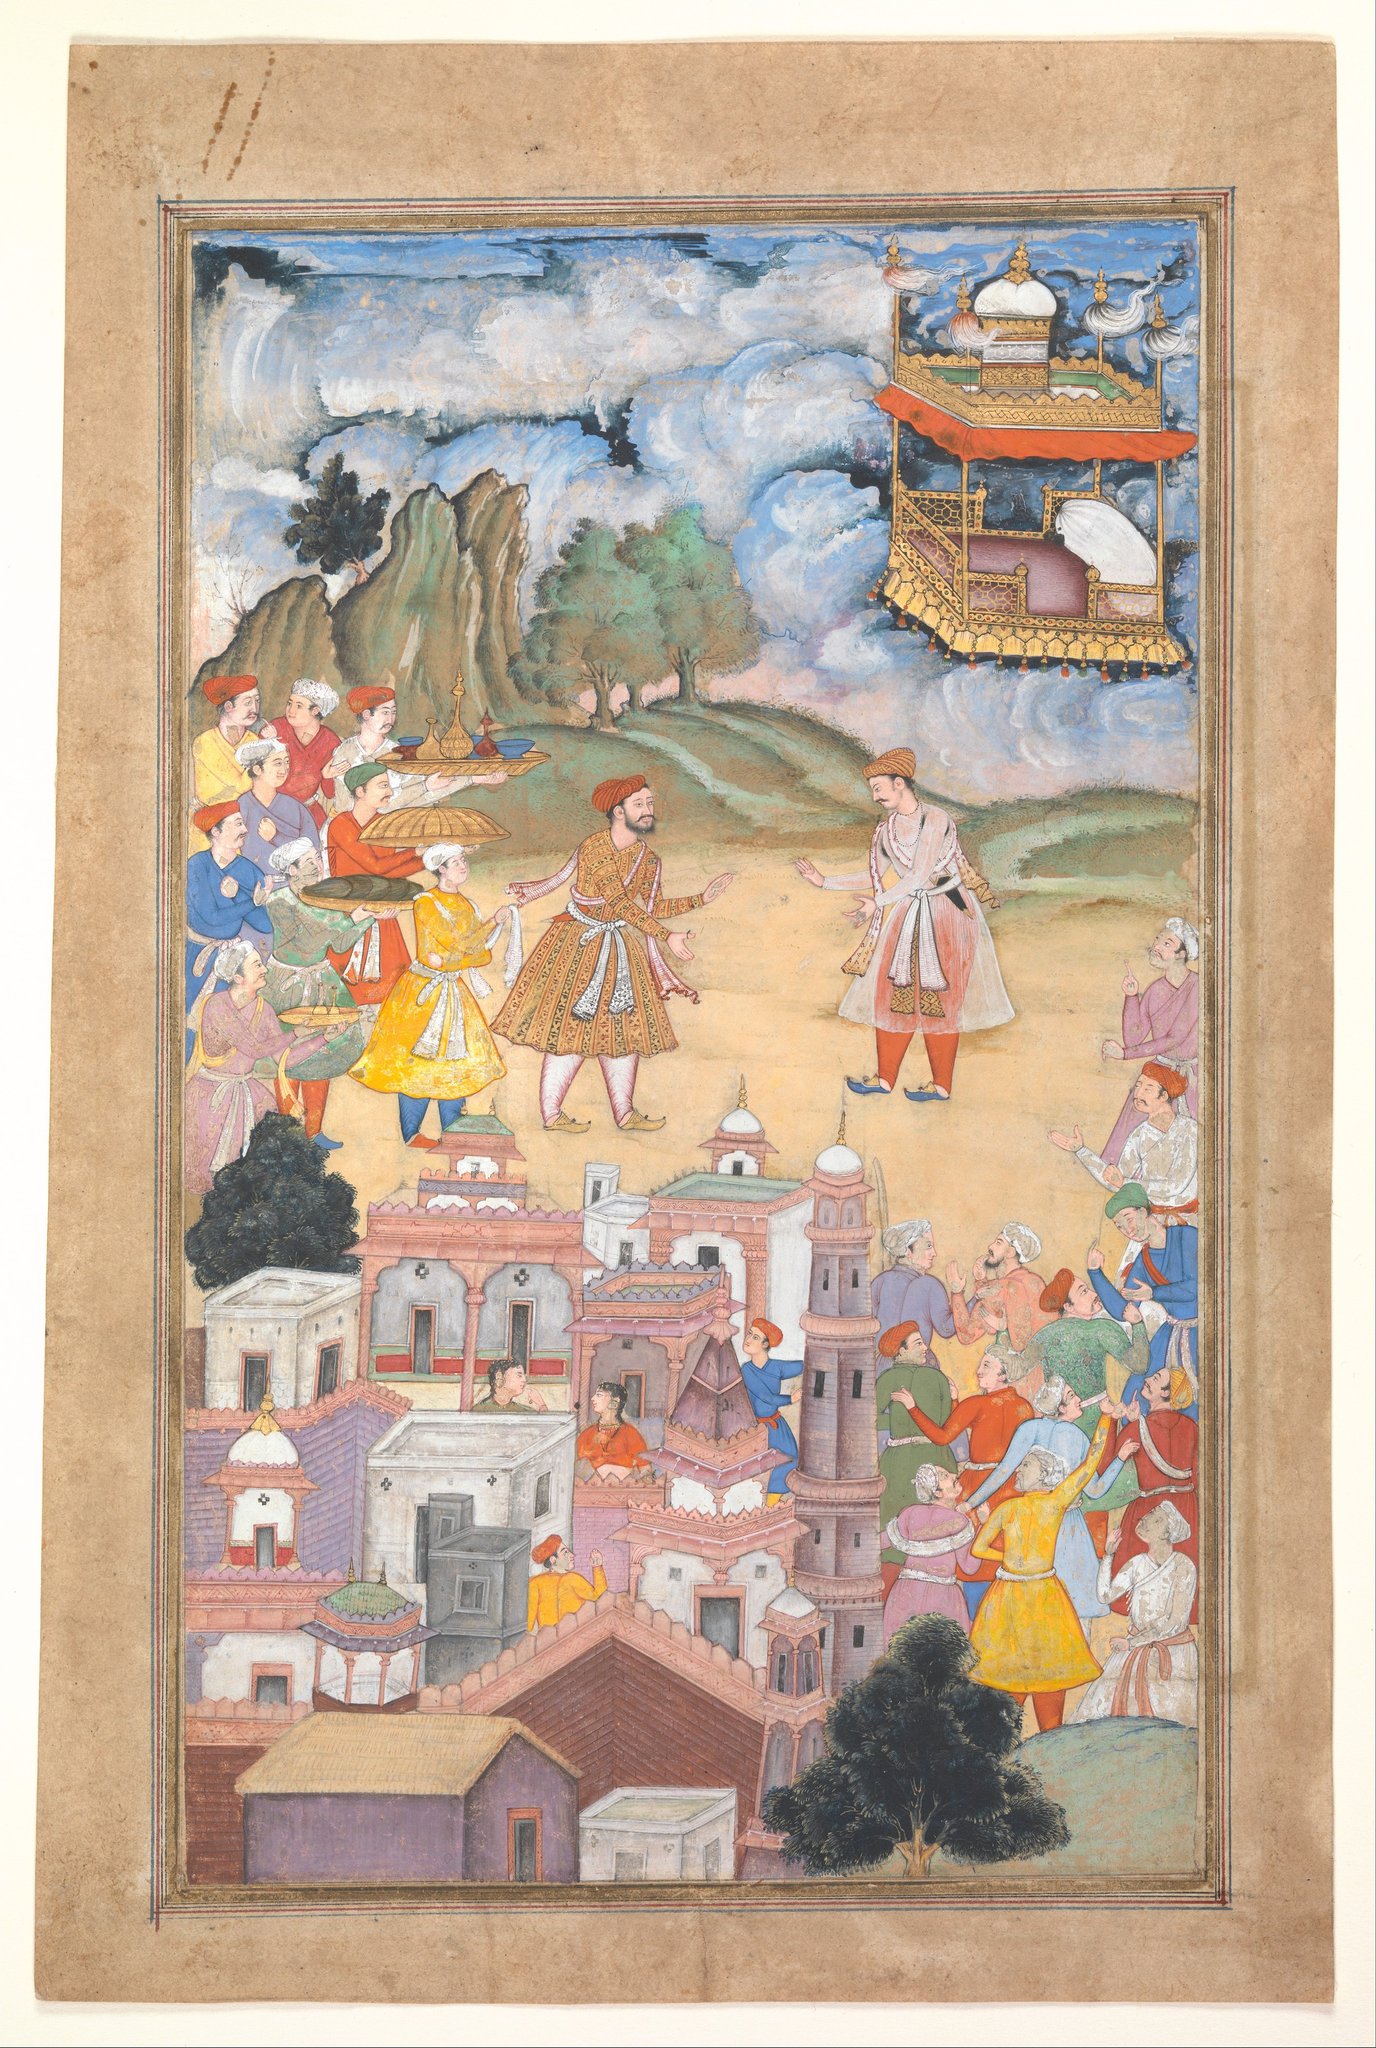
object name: folio from an illustrated manuscript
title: "King Sal Visits Kala Yavana", Folio from a Harivamsa (Legend of Hari (Krishna))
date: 1590-1595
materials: gold, ink, paper, watercolor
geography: pakistan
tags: kings,men,thrones